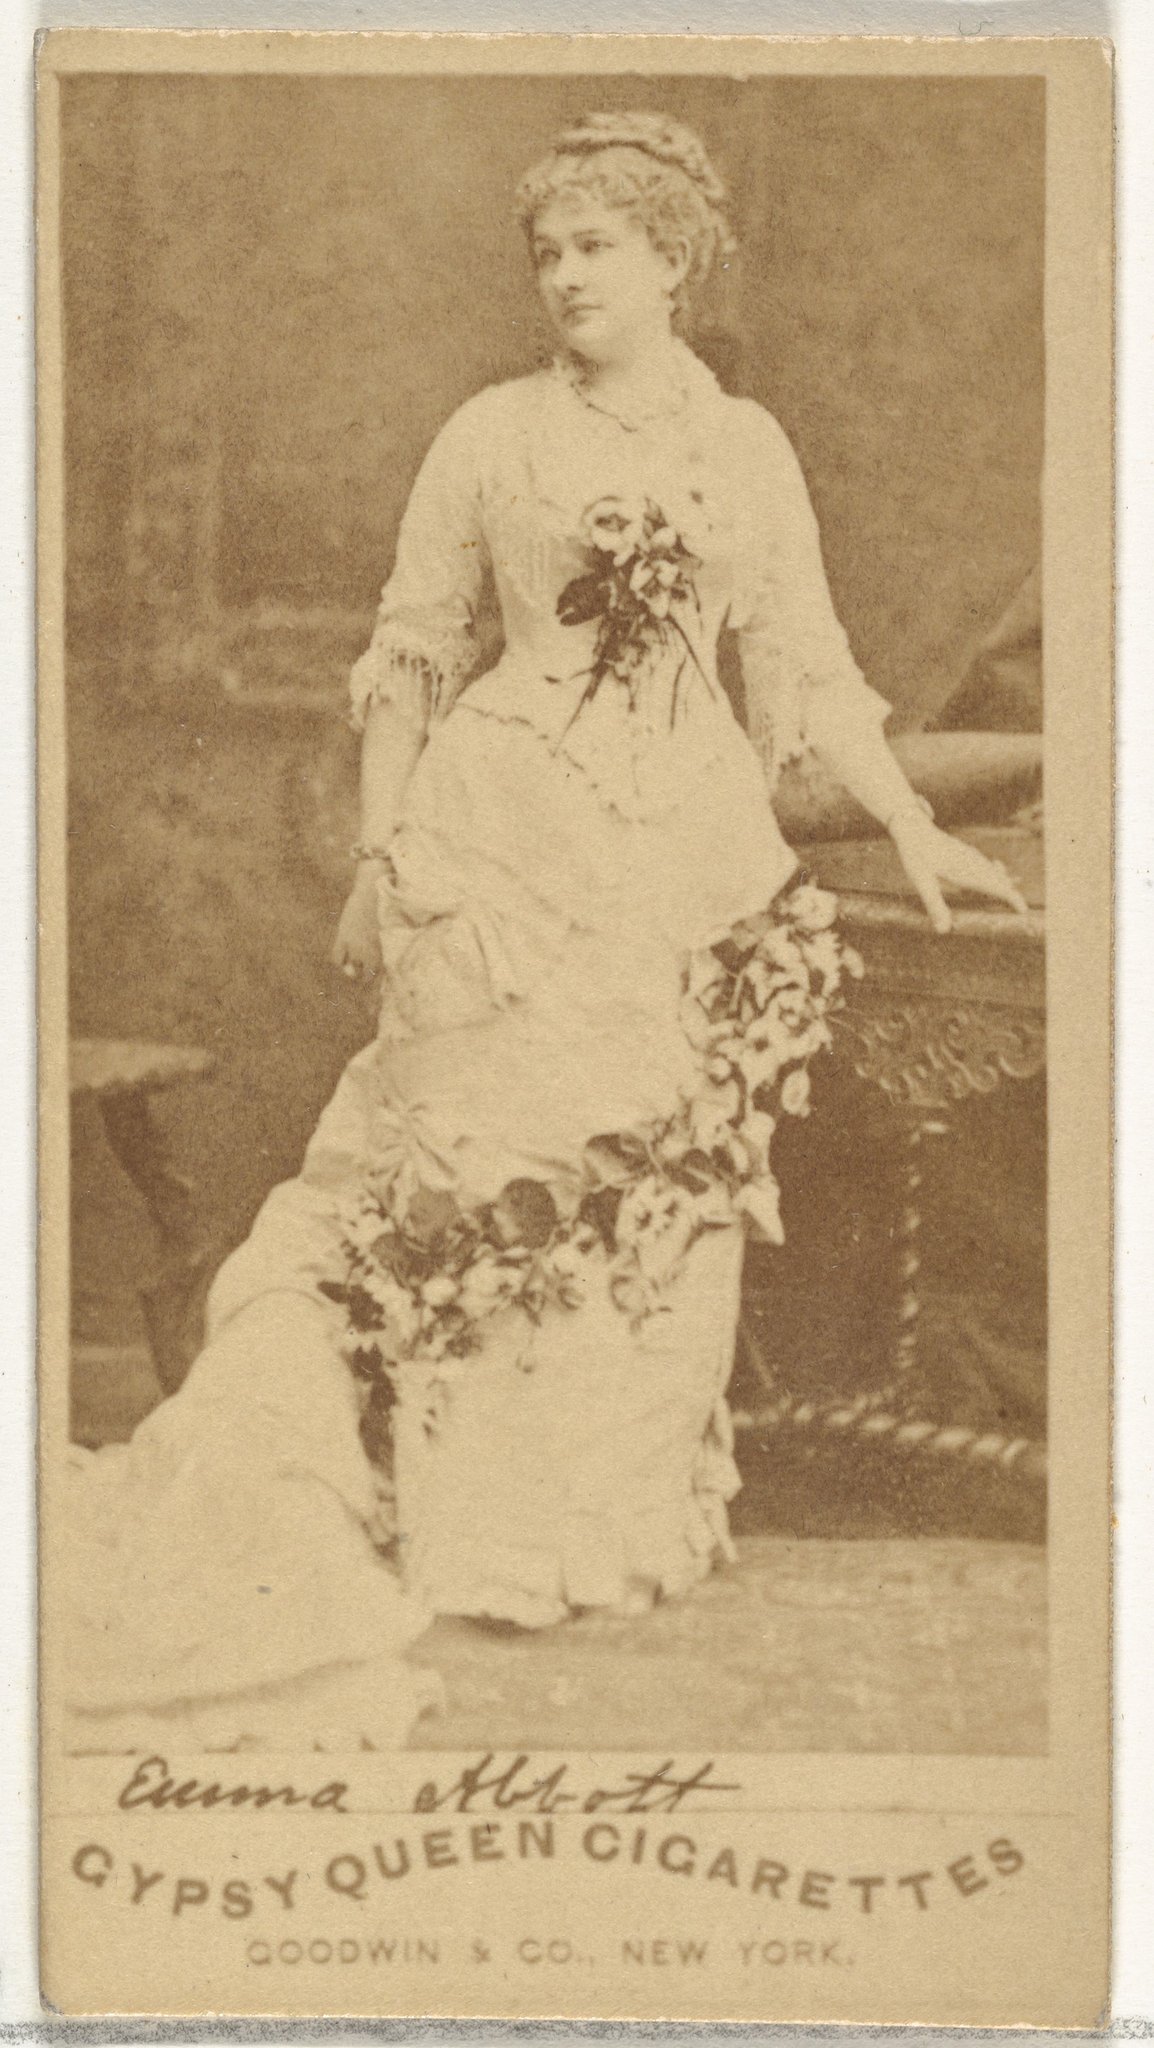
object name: photograph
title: Emma Abbott, from the Actors and Actresses series (N171) for Gypsy Queen Cigarettes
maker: goodwin & company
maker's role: publisher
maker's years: 1850-1950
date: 1886-1890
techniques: albumen silver print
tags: portraits,women,actresses